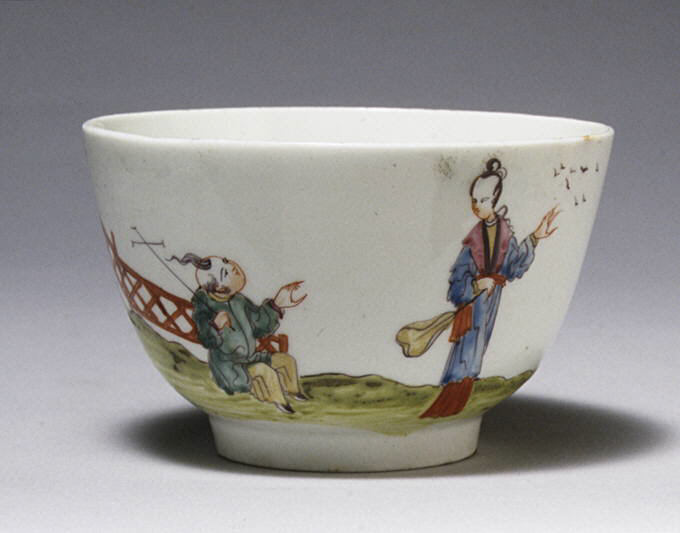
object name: bowl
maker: liverpool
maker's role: factory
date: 1765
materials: soft paste porcelain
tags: human figures,chinoiserie